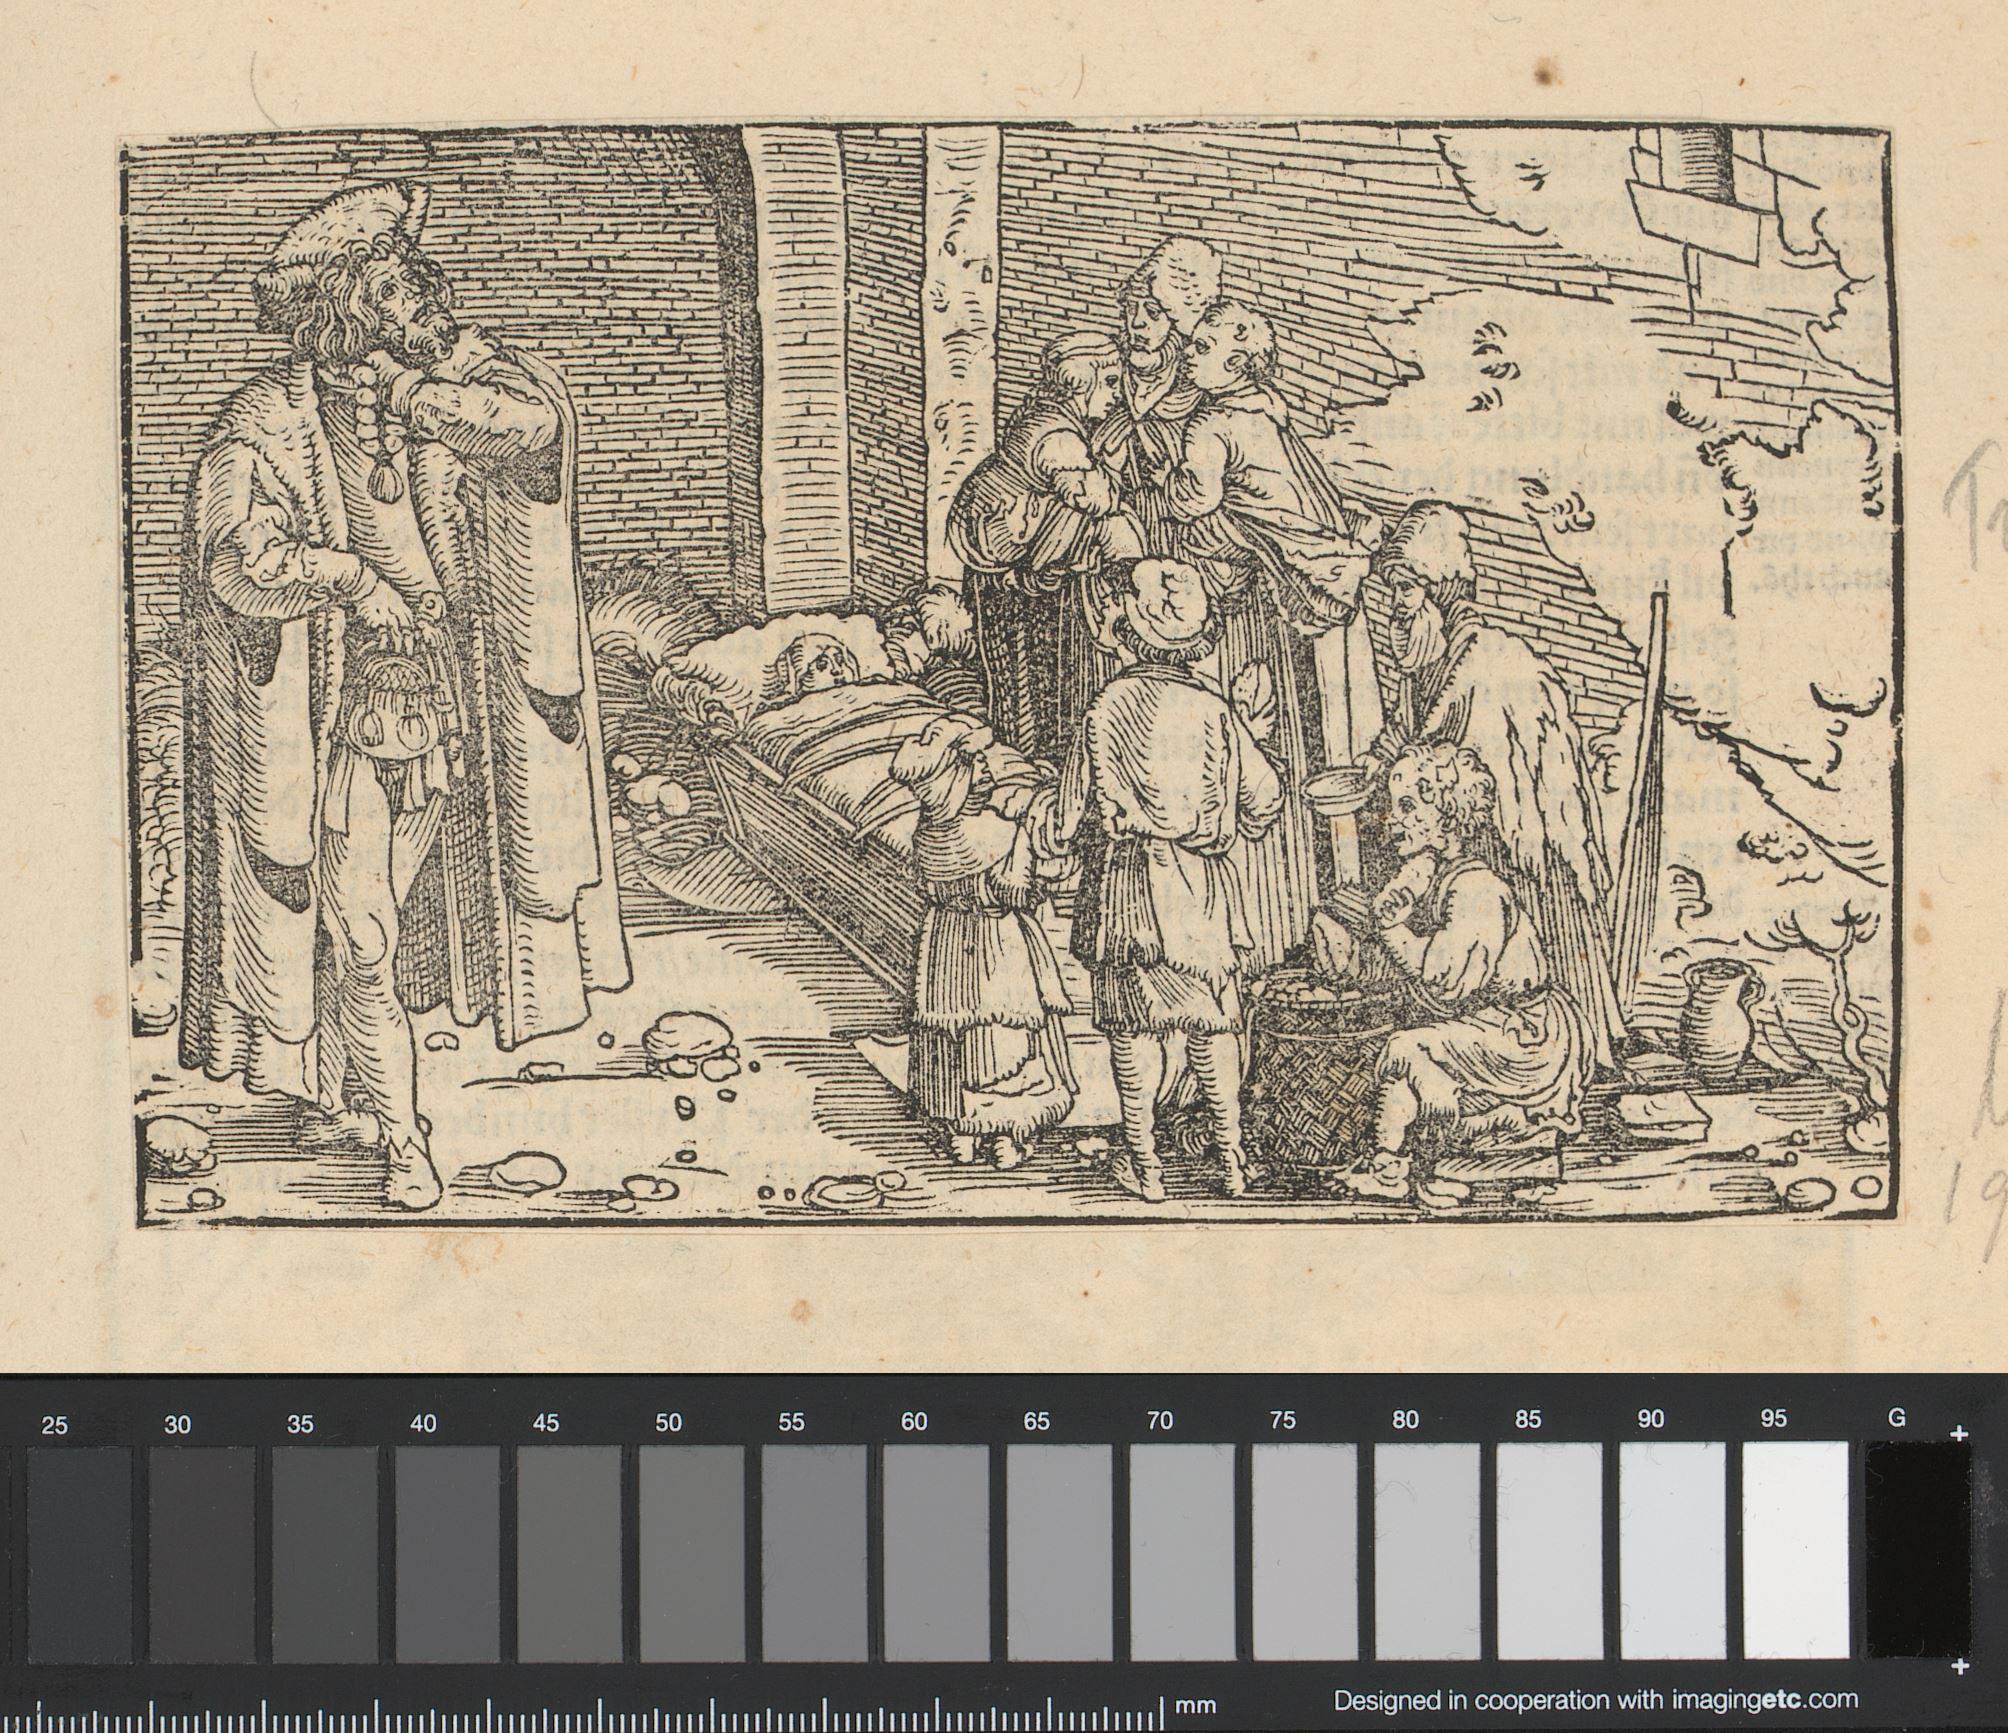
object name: album leaf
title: Rijke man staat bij een arme vrouw met kinderen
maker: Anonymous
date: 1514-1532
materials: paper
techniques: letterpress printing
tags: contrast between rich and poor, mother and child(ren), woman and child(ren) (family group)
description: Deze prent is gebruikt in: Petrarca, Francesco. Von der Artzney bayder Glück, des guten und widerwertigen: unnd weß sich ain yeder inn Gelück und Unglück halten sol (...). Augsburg: Heinrich Steiner, 1532. Deze uitgave is ook bekend onder de titel 'Trostspiegel in Glück und Unglück'.